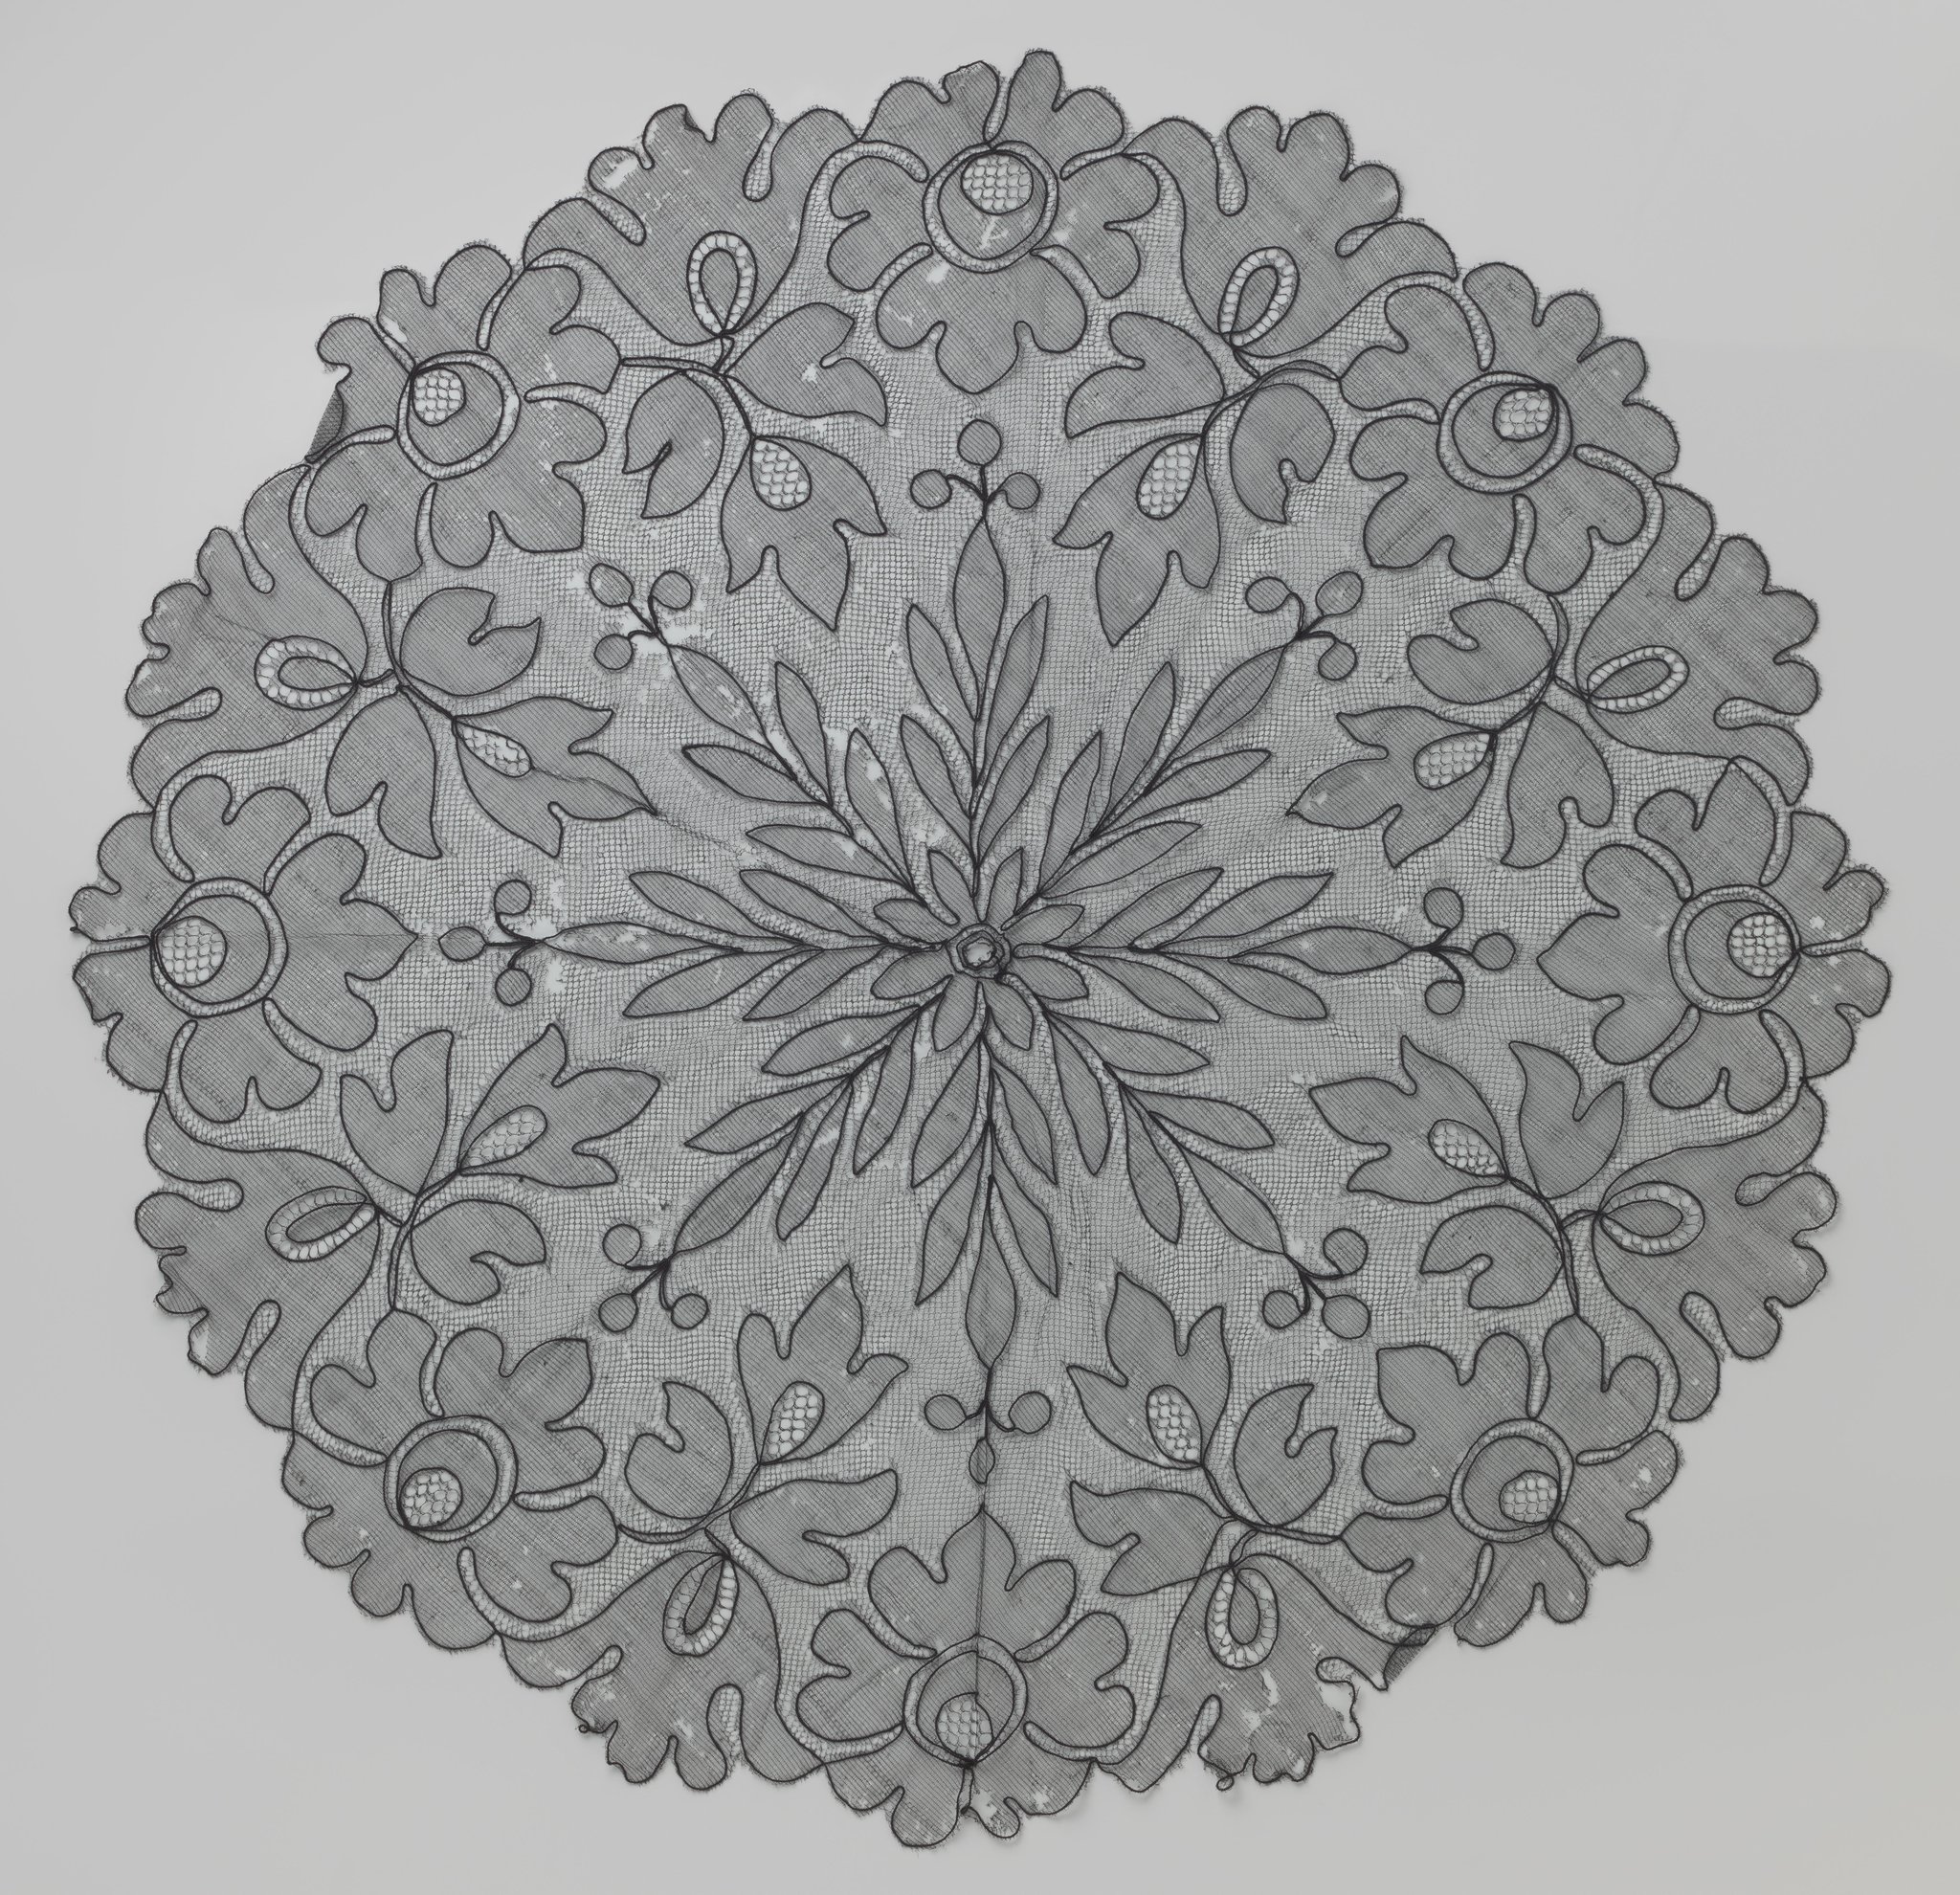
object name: womenswear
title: Parasoldek van zwart gaas met acht ingeweven bladtakken met bessen en rand van grote bloemen en bladeren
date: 1875-1900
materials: textile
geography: switzerland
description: Parasoldek van zwart gaas met acht ingeweven bladtakken met bessen en rand van grote bloemen en bladeren. Het dek is rond en heeft een geschulpte rand.